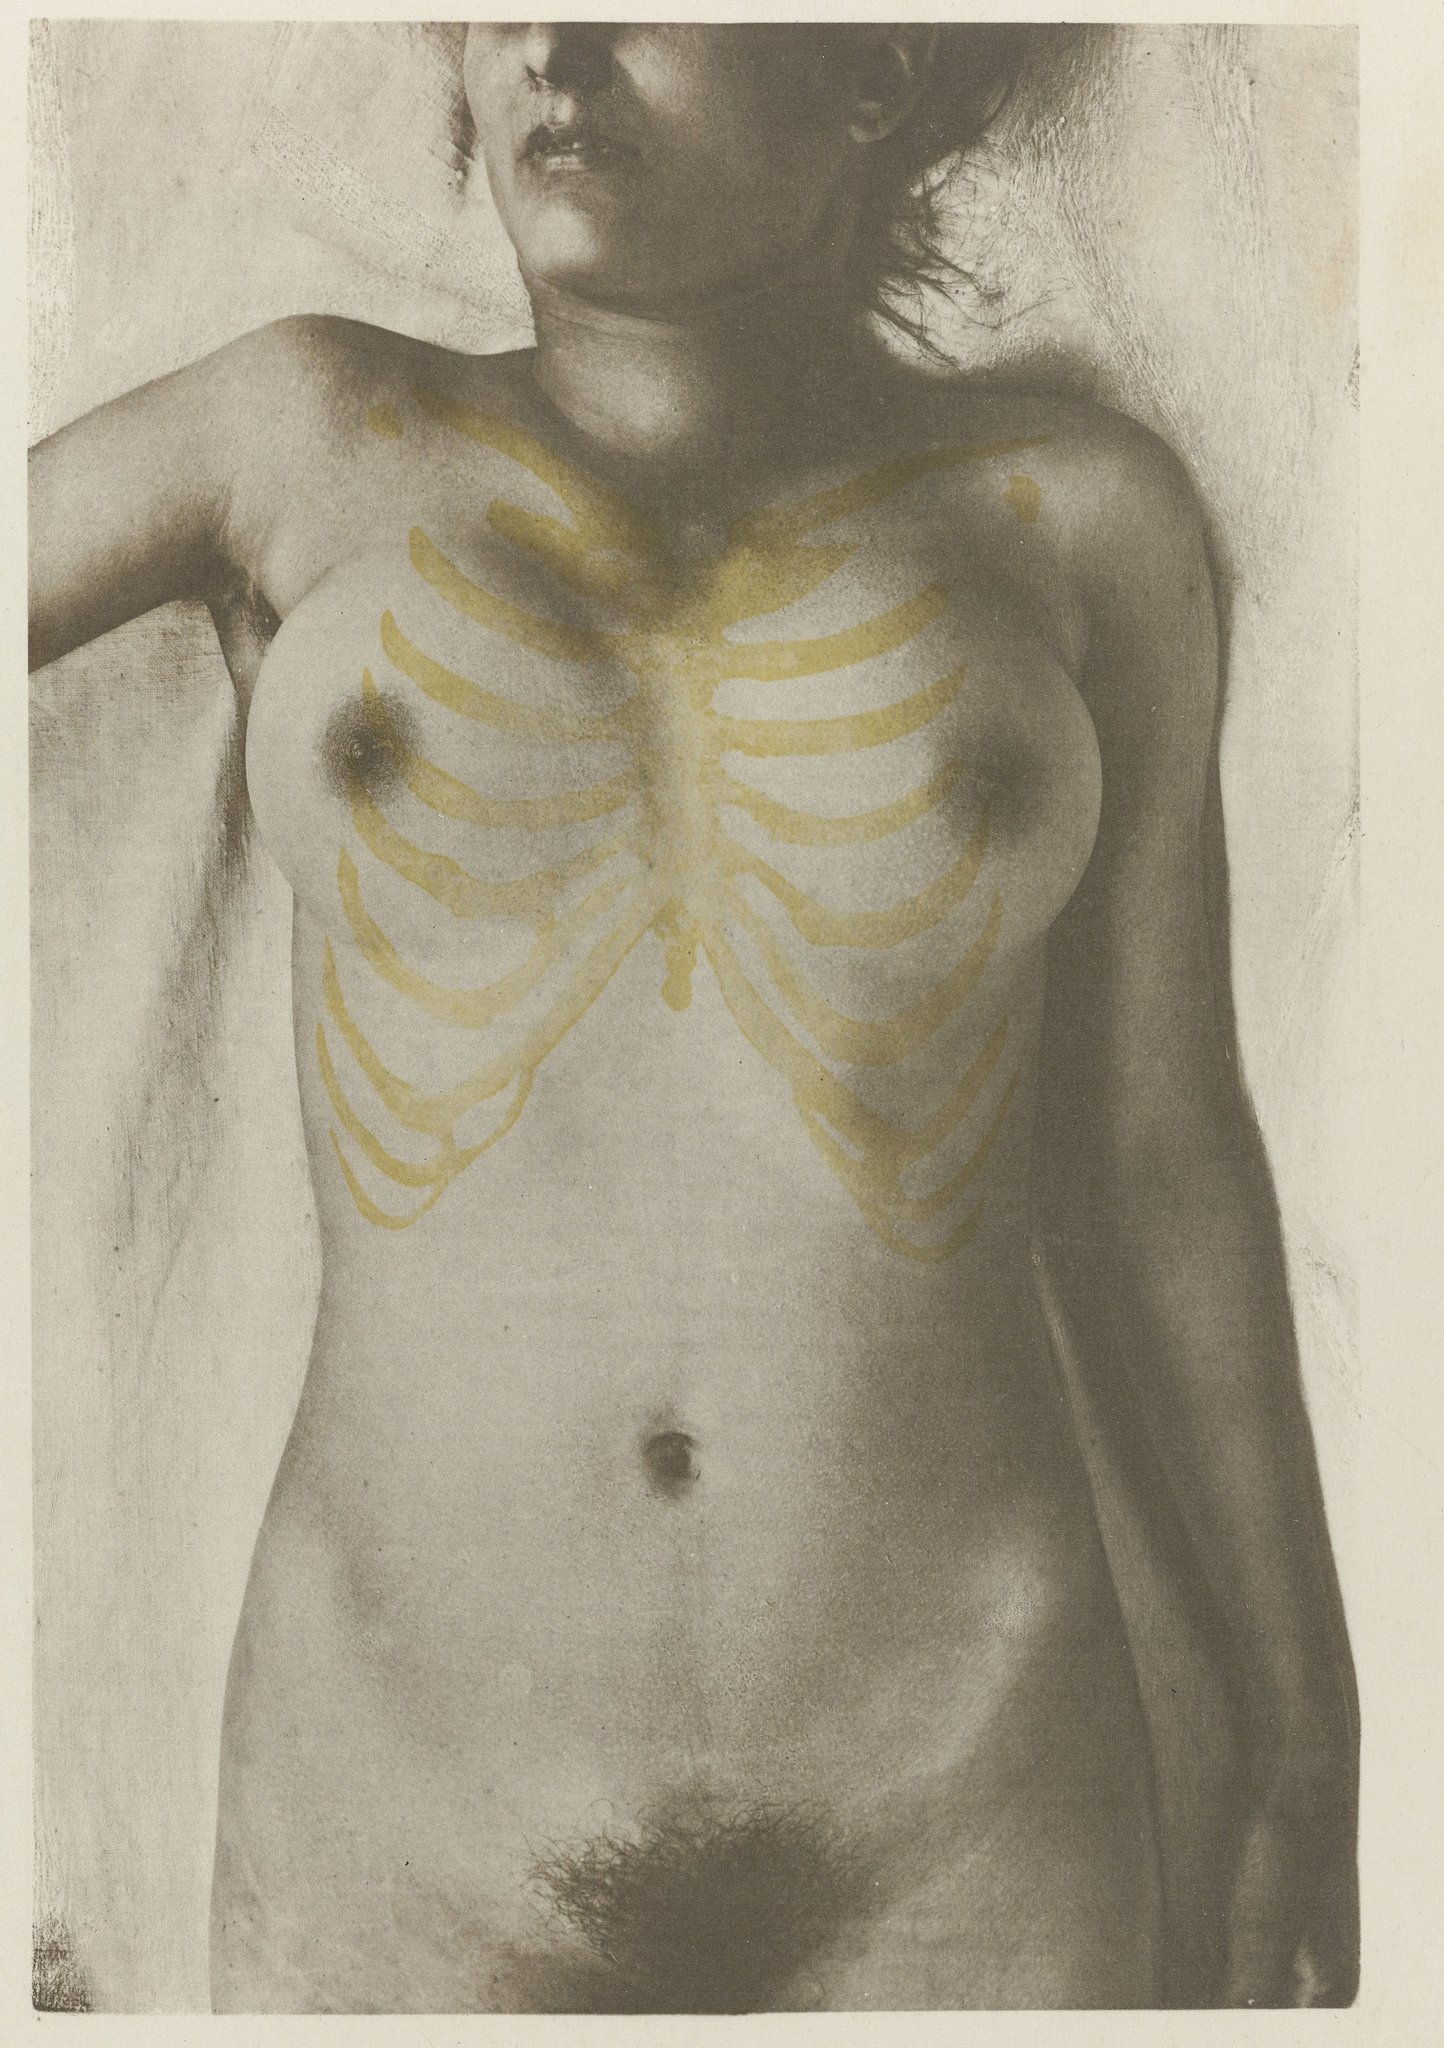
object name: photograph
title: Atlas der Anatomie des Menschen zum Gebrauch für Künstler : Reproduktion und Illustration, anatomischer Präparate, Musterbilder und Kunstwerke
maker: giulio chiarugi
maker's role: anatoom, embryoloog, fotograaf, schrijver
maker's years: 1859-1944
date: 1908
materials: cardboard, paper, photographic support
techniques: photograph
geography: florence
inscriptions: stamp: ‘Rijksschool voor Kunstnijverheid’